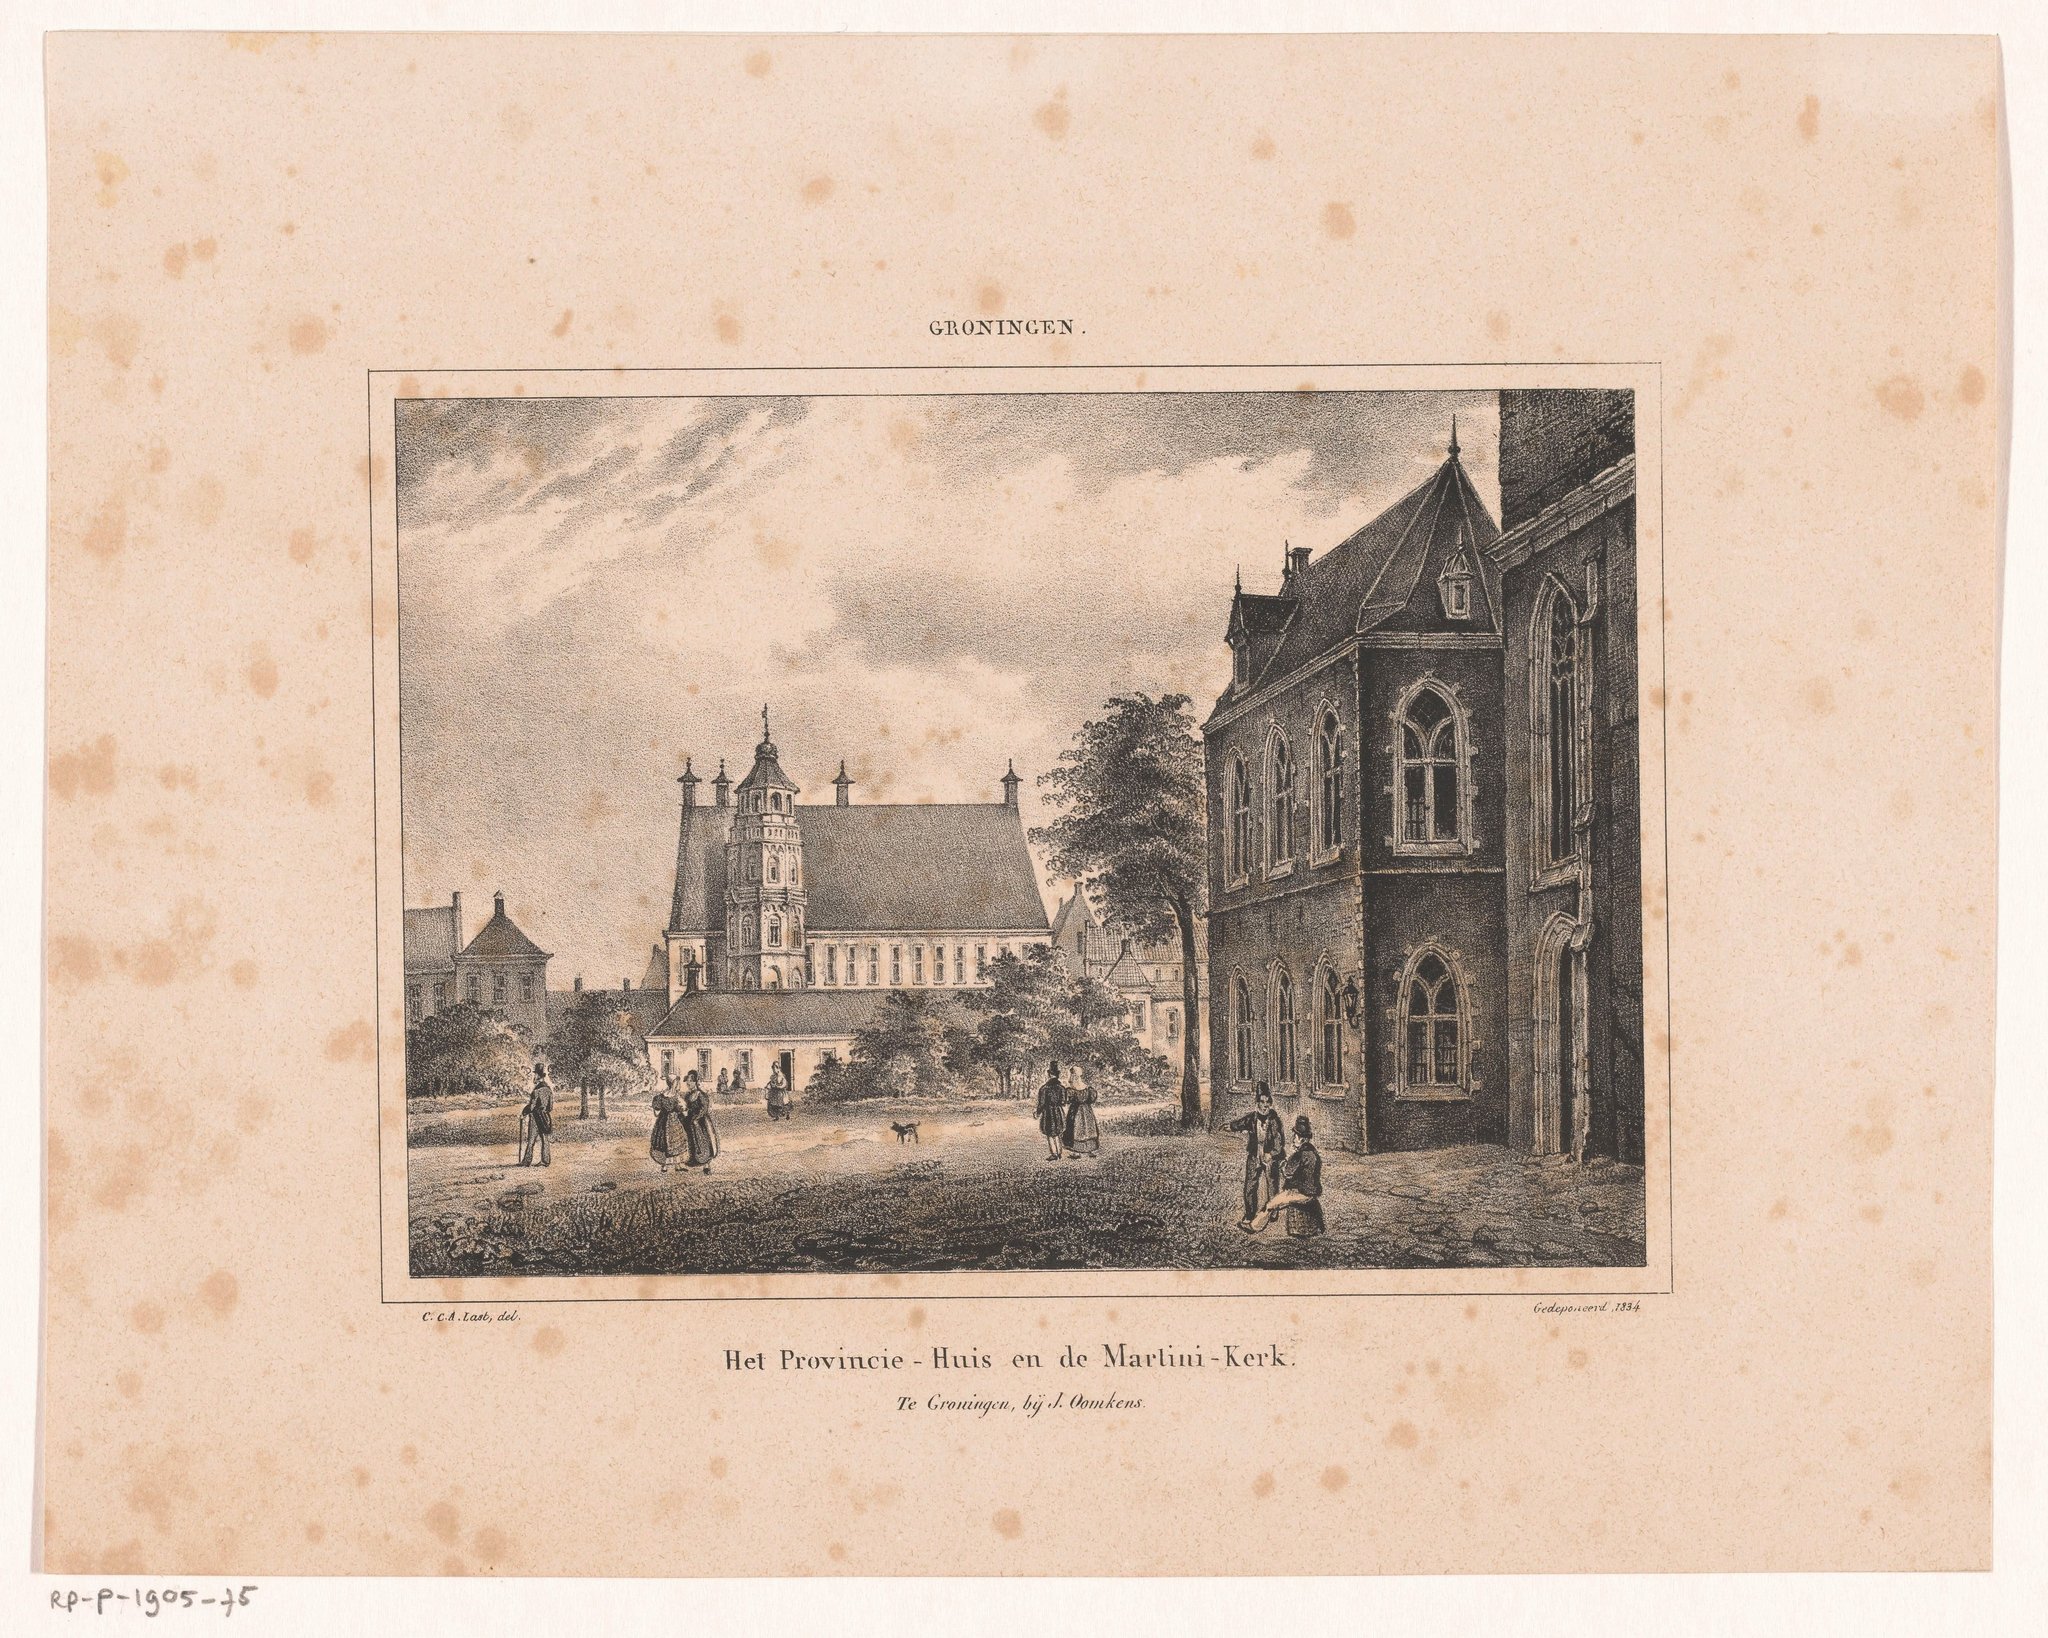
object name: print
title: Provinciehuis en Martinikerk te Groningen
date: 1834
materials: paper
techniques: lithograph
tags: church (exterior), village (+ city(-scape) with figures, staffage)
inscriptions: : ‘Gedeponeerd 1834.’, collector's mark: Lugt 2228